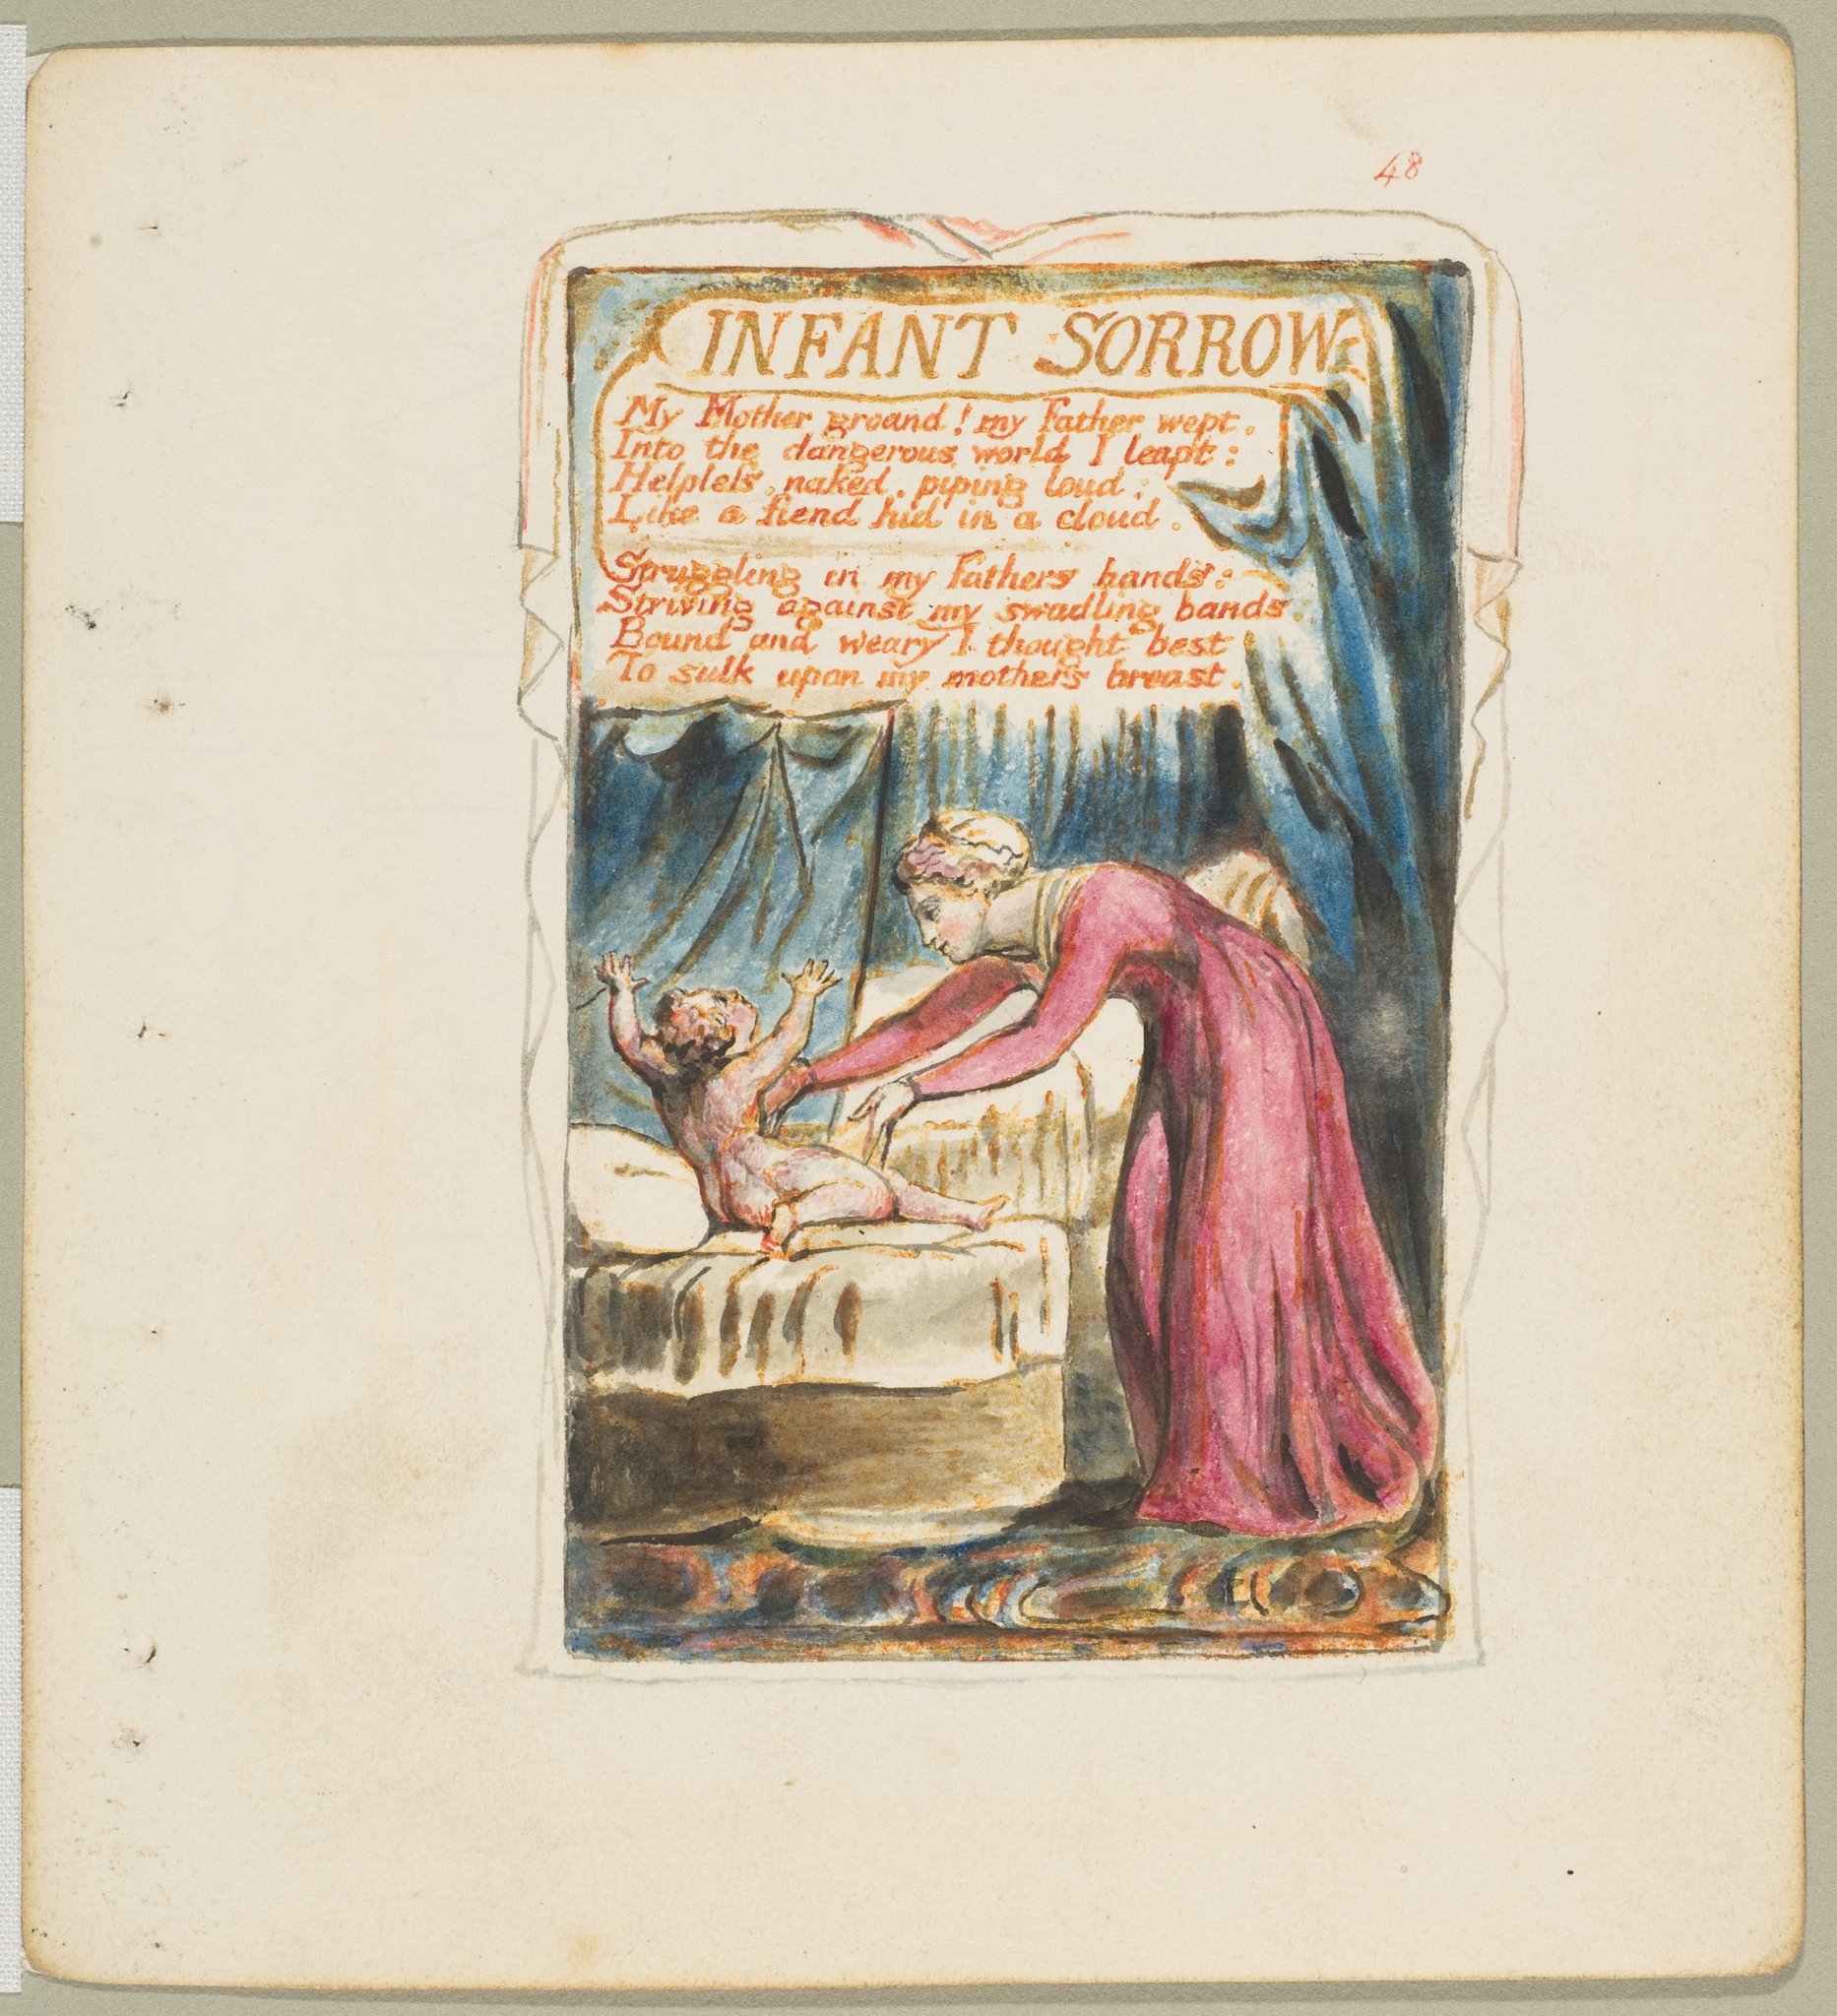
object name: print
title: Songs of Experience: Infant Sorrow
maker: william blake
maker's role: artist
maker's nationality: british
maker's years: 1757-1827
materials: gold, ink, shell, watercolor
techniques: etching, hand coloring, printing, relief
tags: infants,women